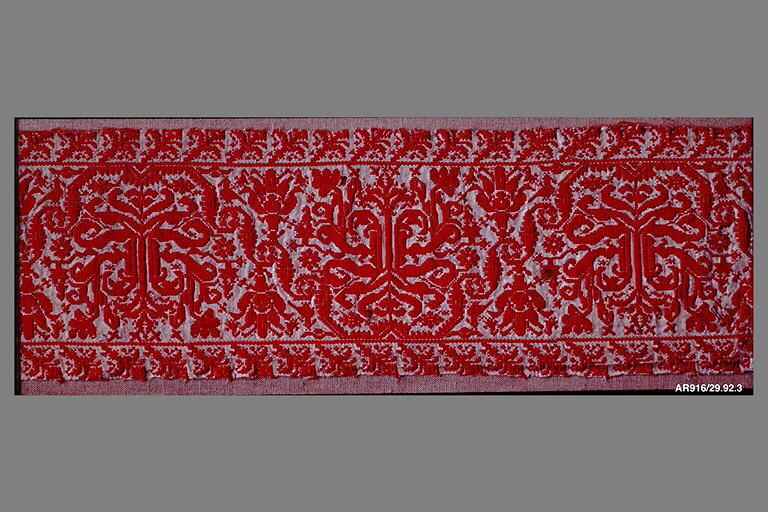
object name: border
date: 1601-1800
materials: linen, silk